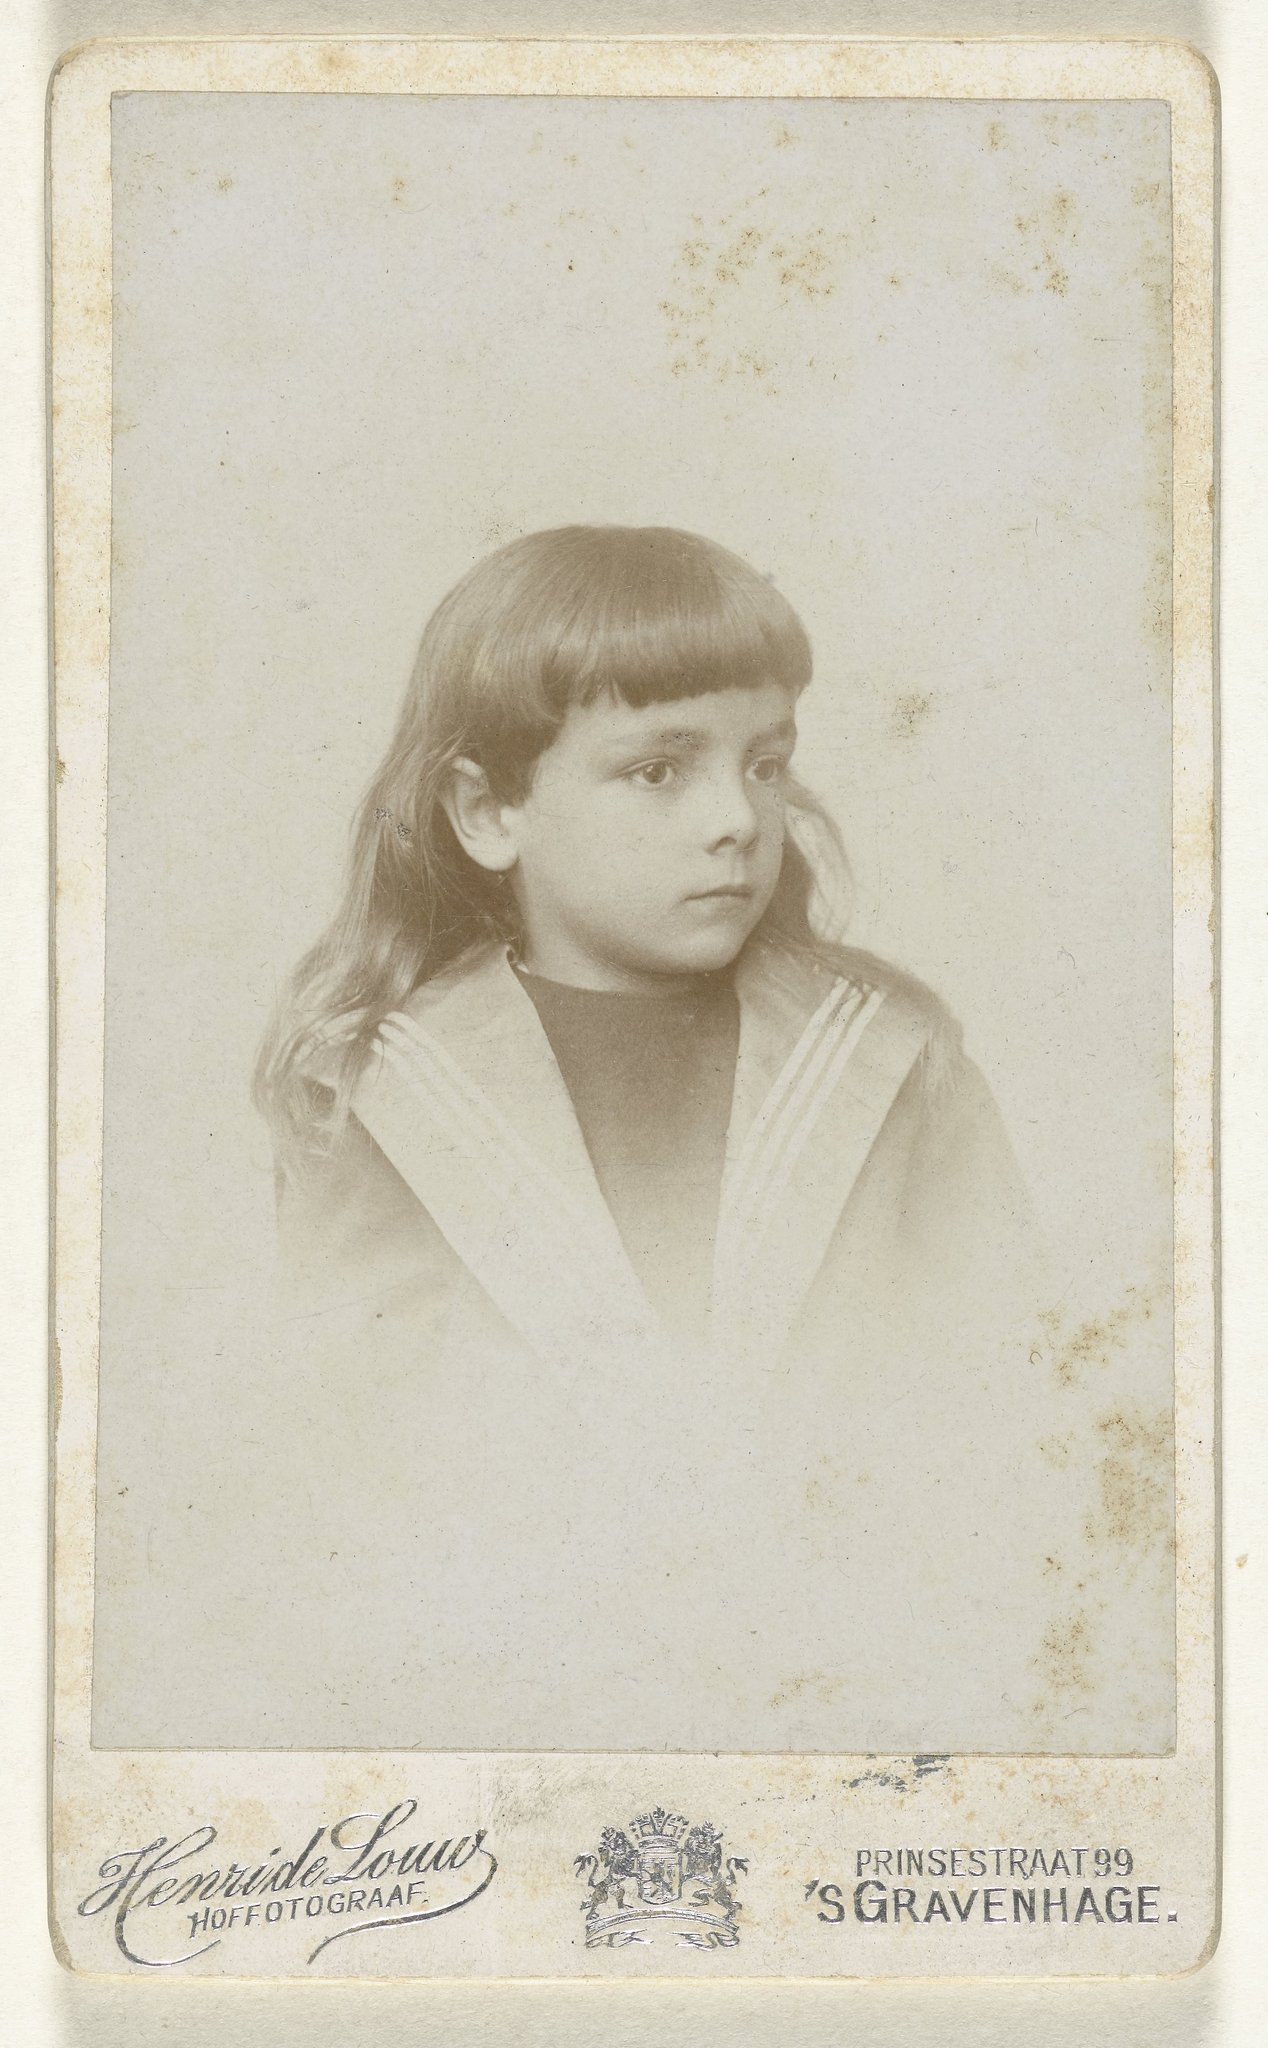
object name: photograph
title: Studioportret van een meisje in matrozenpak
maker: henri de louw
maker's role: fotograaf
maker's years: 1851-1944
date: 1890-1915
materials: paper, photographic support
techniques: photography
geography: the hague